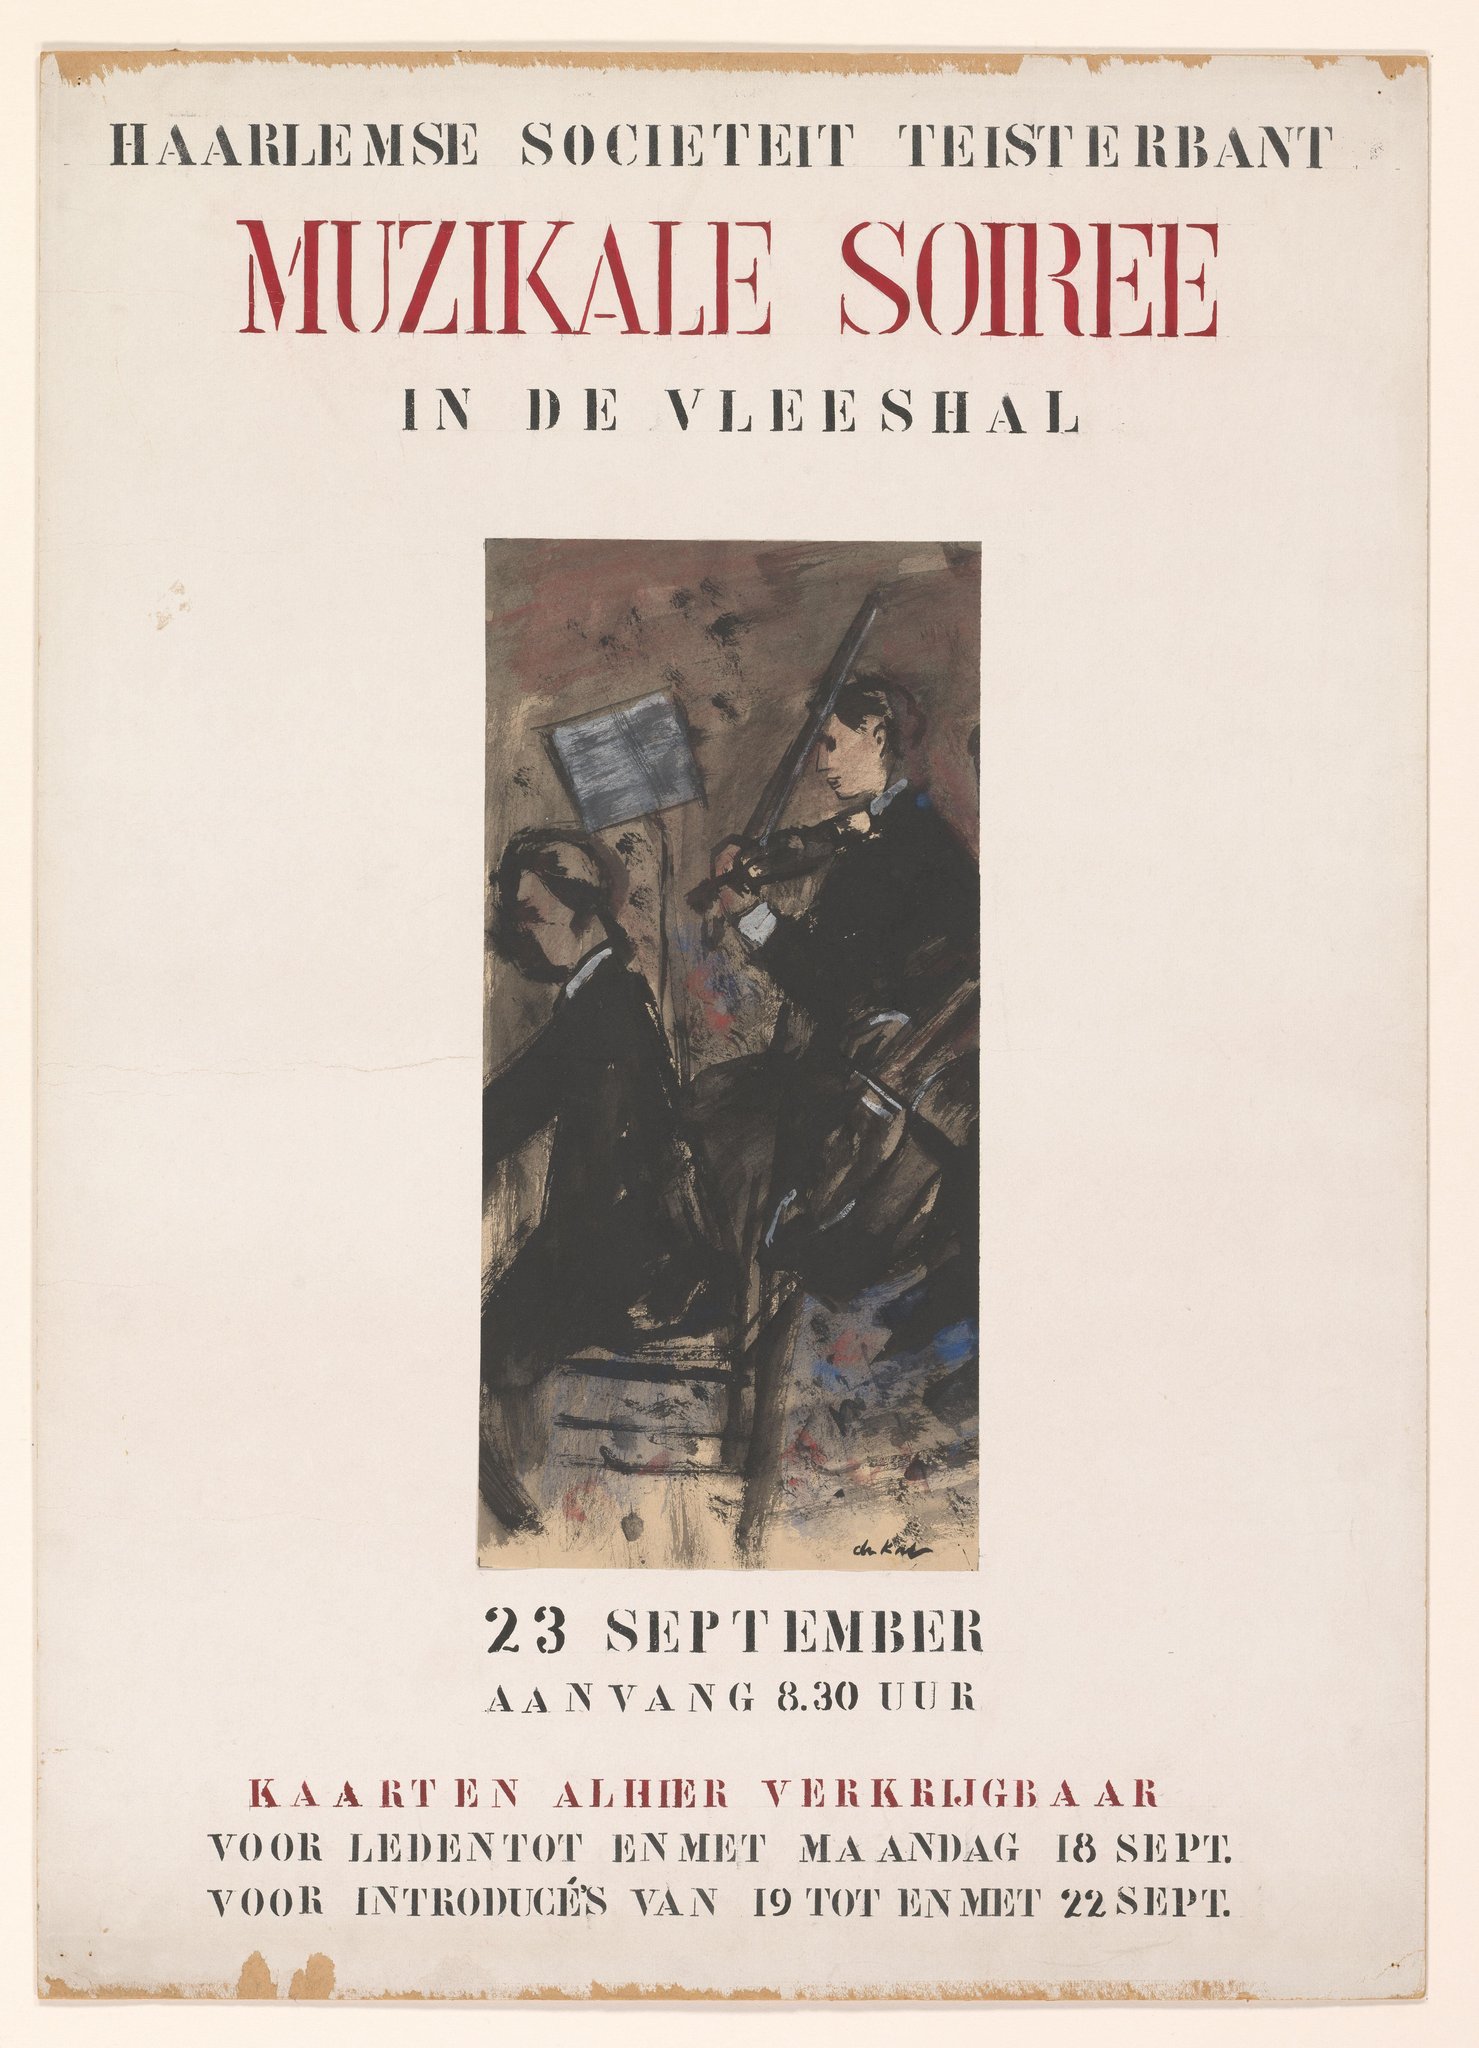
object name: print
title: Adrien Ostade (dans son atelier)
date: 1822-1843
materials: paper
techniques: engraving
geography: leipzig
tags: portrait, self-portrait of painter, painter at work, in his studio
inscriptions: collector's mark: Lugt 2228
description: Vertaling van 'dans son atelier' in het Engels, Duits en Italiaans in de ondermarge.